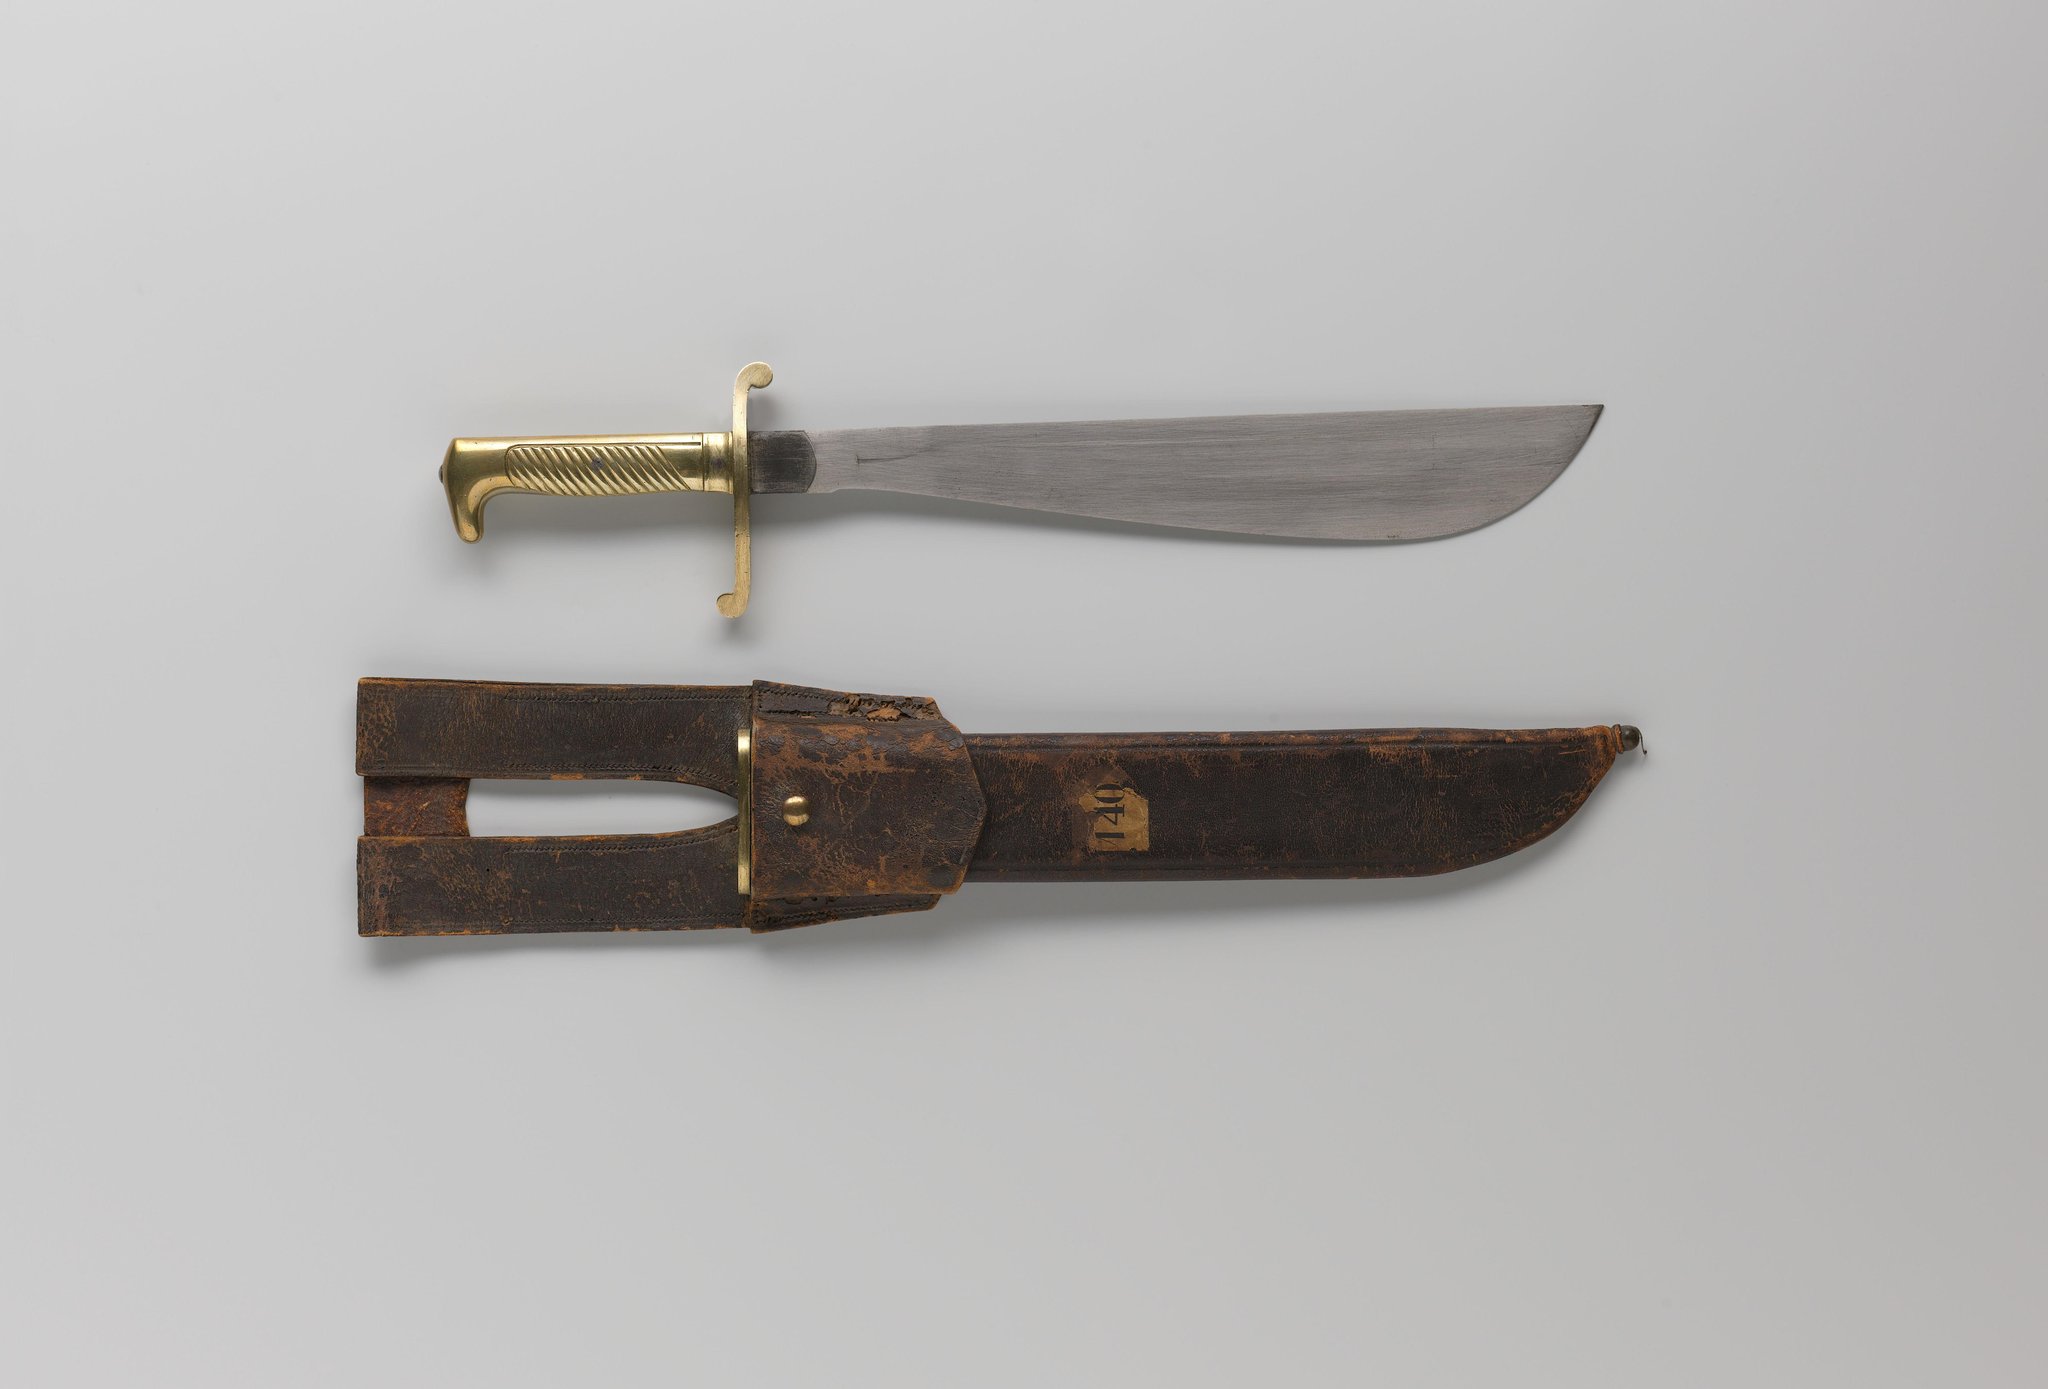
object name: machete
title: Broad-bladed knife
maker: Anonymous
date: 1879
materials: brass, copper, iron, leather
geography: netherlands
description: Kapmes met korte kling met rechte rug en gekromde snede. Het gevest is geheel van geelkoper, met een gegroefde greep en stootplaat met eindknoppen. De onderband met eindknop is geheel binnen de leren schede genaaid, zodat alleen de knop uitsteekt. De messing bovenband heeft een koperen draagknop voor de draagband, die aan een broekriem gedragen moet worden.